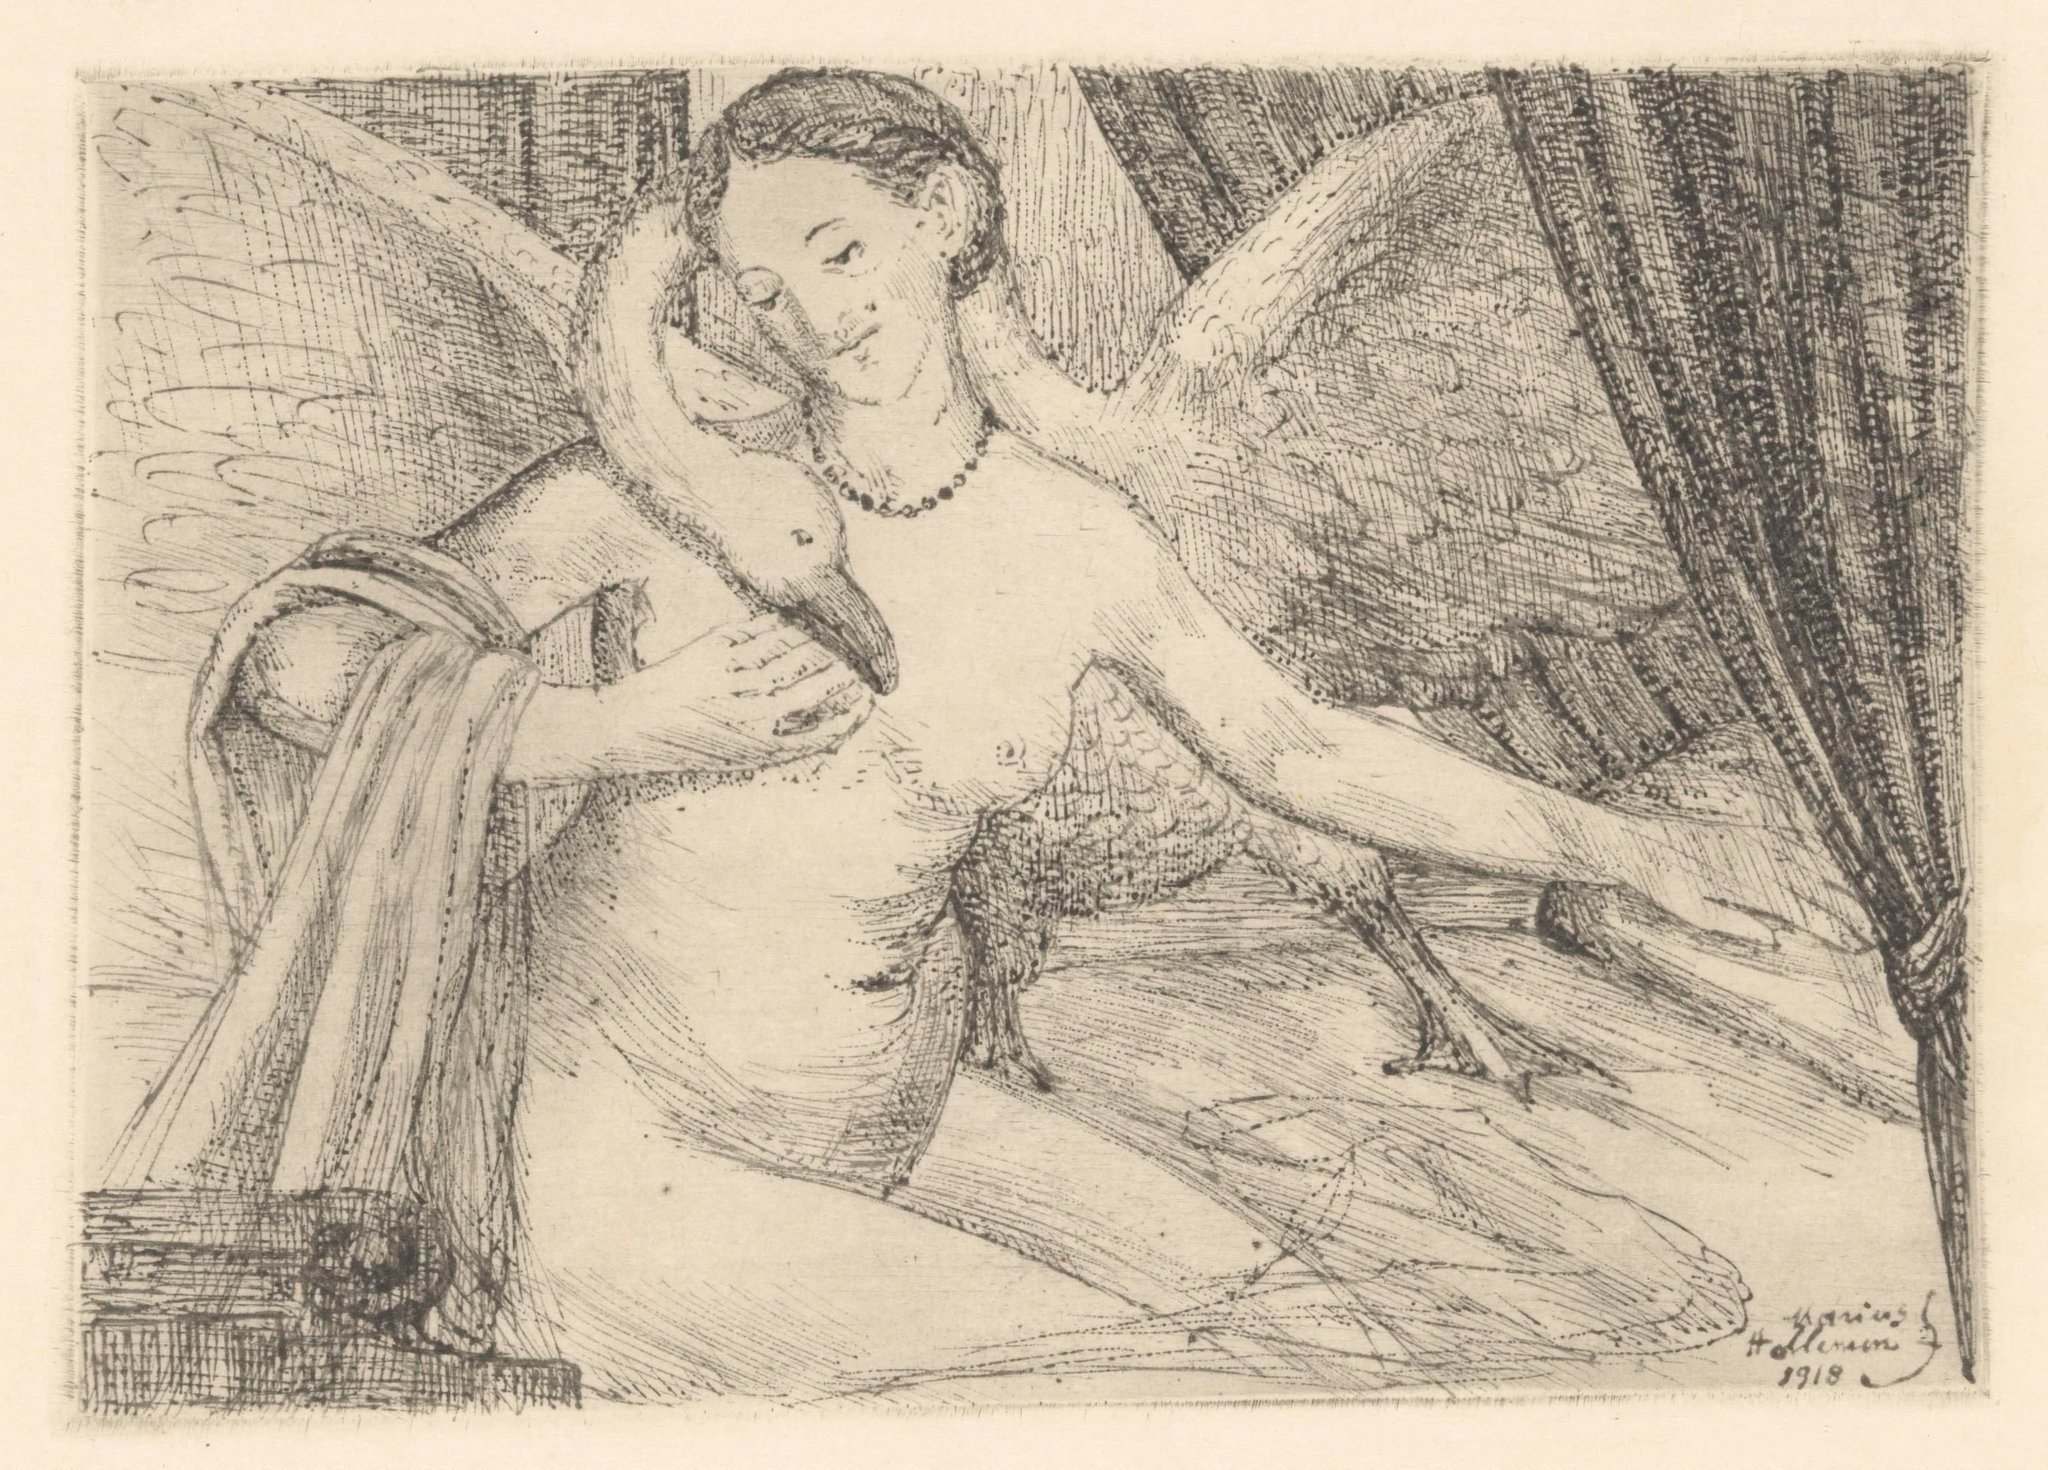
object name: print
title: Leda en de zwaan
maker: marius holleman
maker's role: draughtsman, print maker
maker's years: 1878-1926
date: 1918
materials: paper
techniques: etching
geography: groningen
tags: jupiter, in the shape of a swan, and leda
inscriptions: collector's mark: Lugt 2228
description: Leda zit op een bed. De zwaan (Jupiter) staat met gespreide vleugels achter haar en legt zijn kop op haar borst.